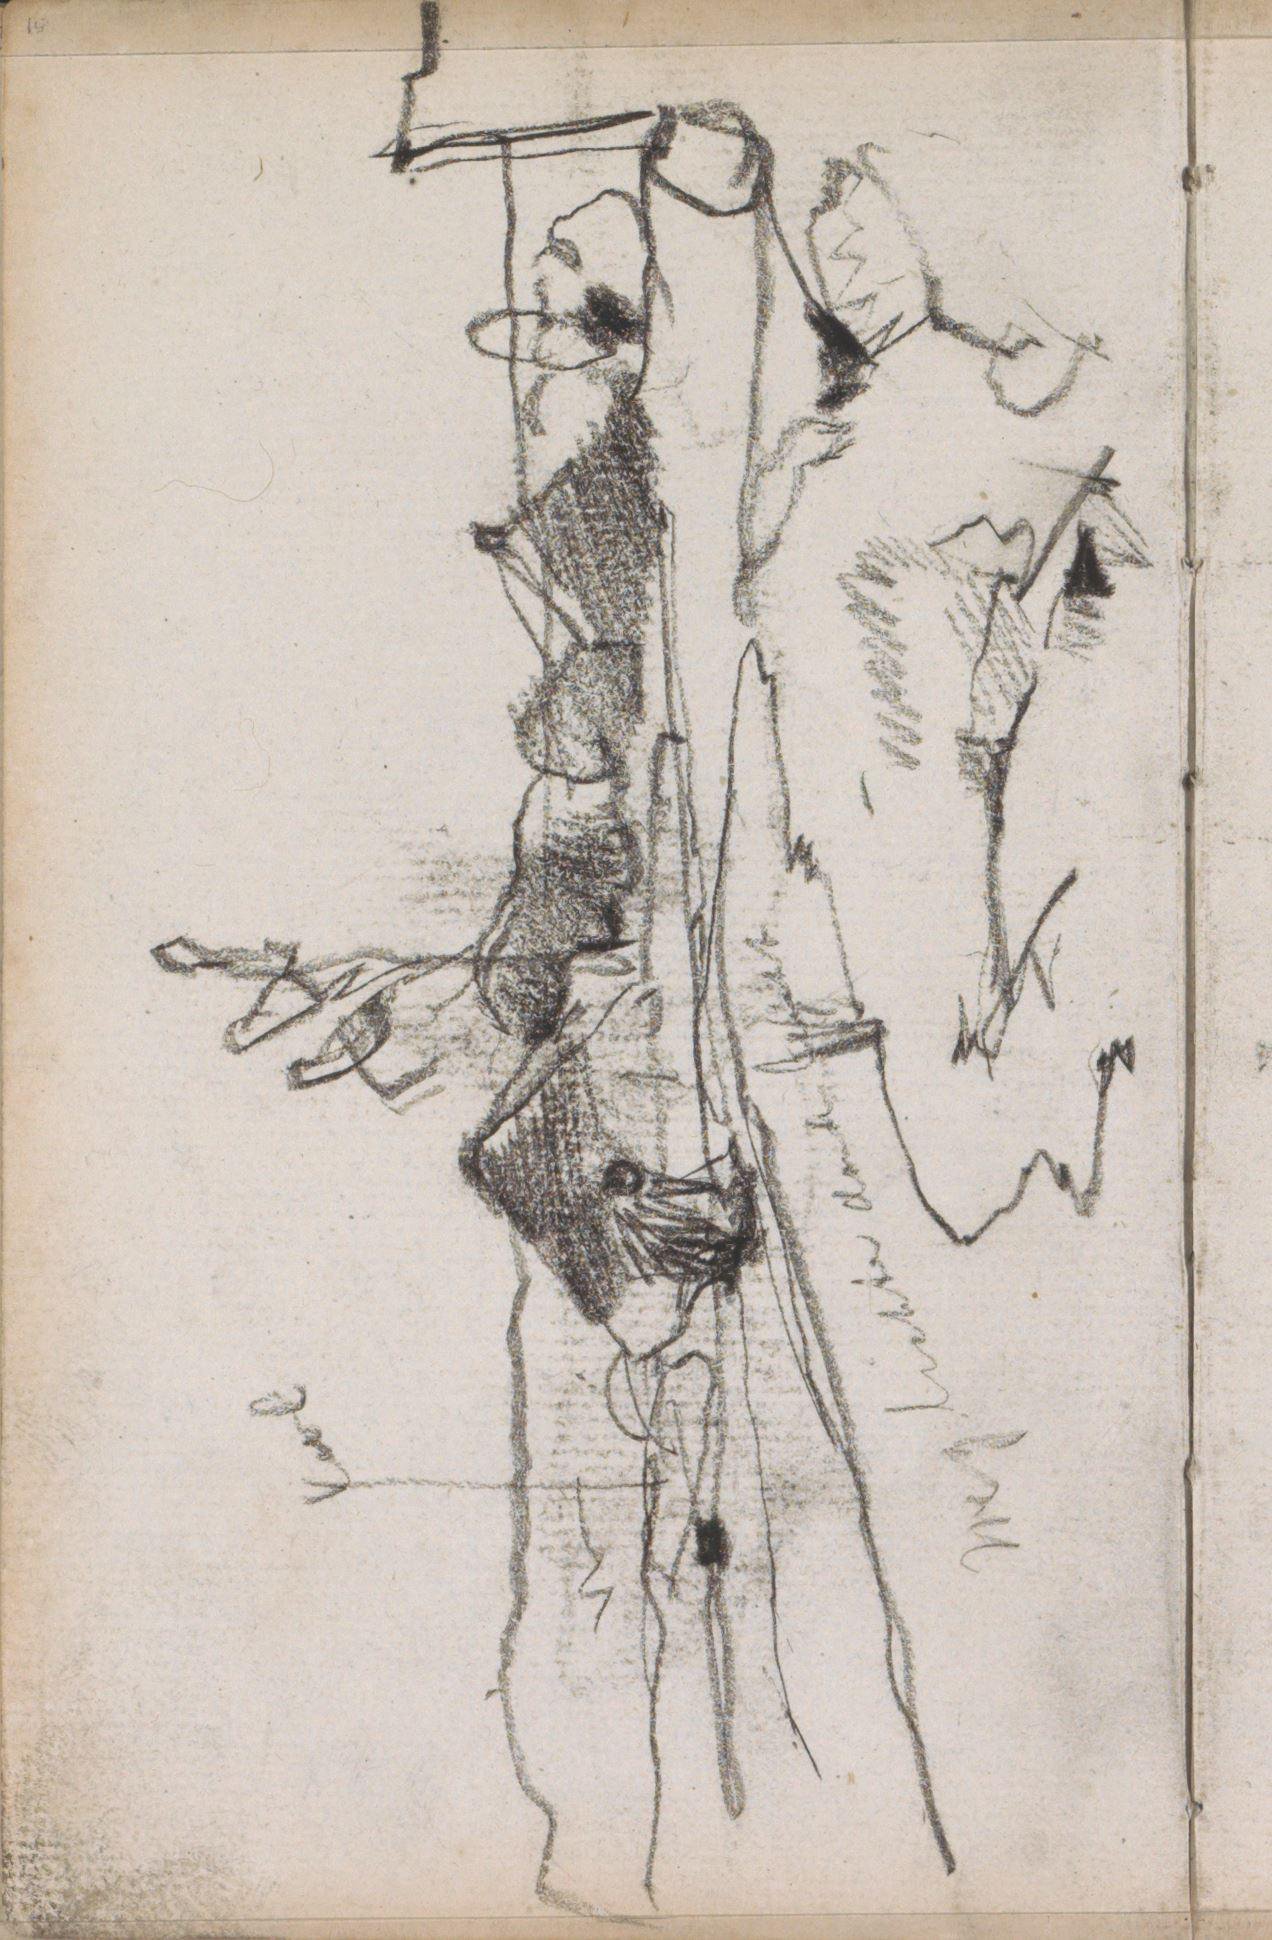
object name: sketchbook leaf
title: Landschap met boerderijen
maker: george hendrik breitner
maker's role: draughtsman, painter, print maker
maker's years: 1857-1923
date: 1884-1886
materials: chalk, paper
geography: drenthe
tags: landscapes, farm (building)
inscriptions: kleurnotitie, handgeschreven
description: Pagina 15 uit een schetsboek met 67 bladen vervaardigd in Drenthe.